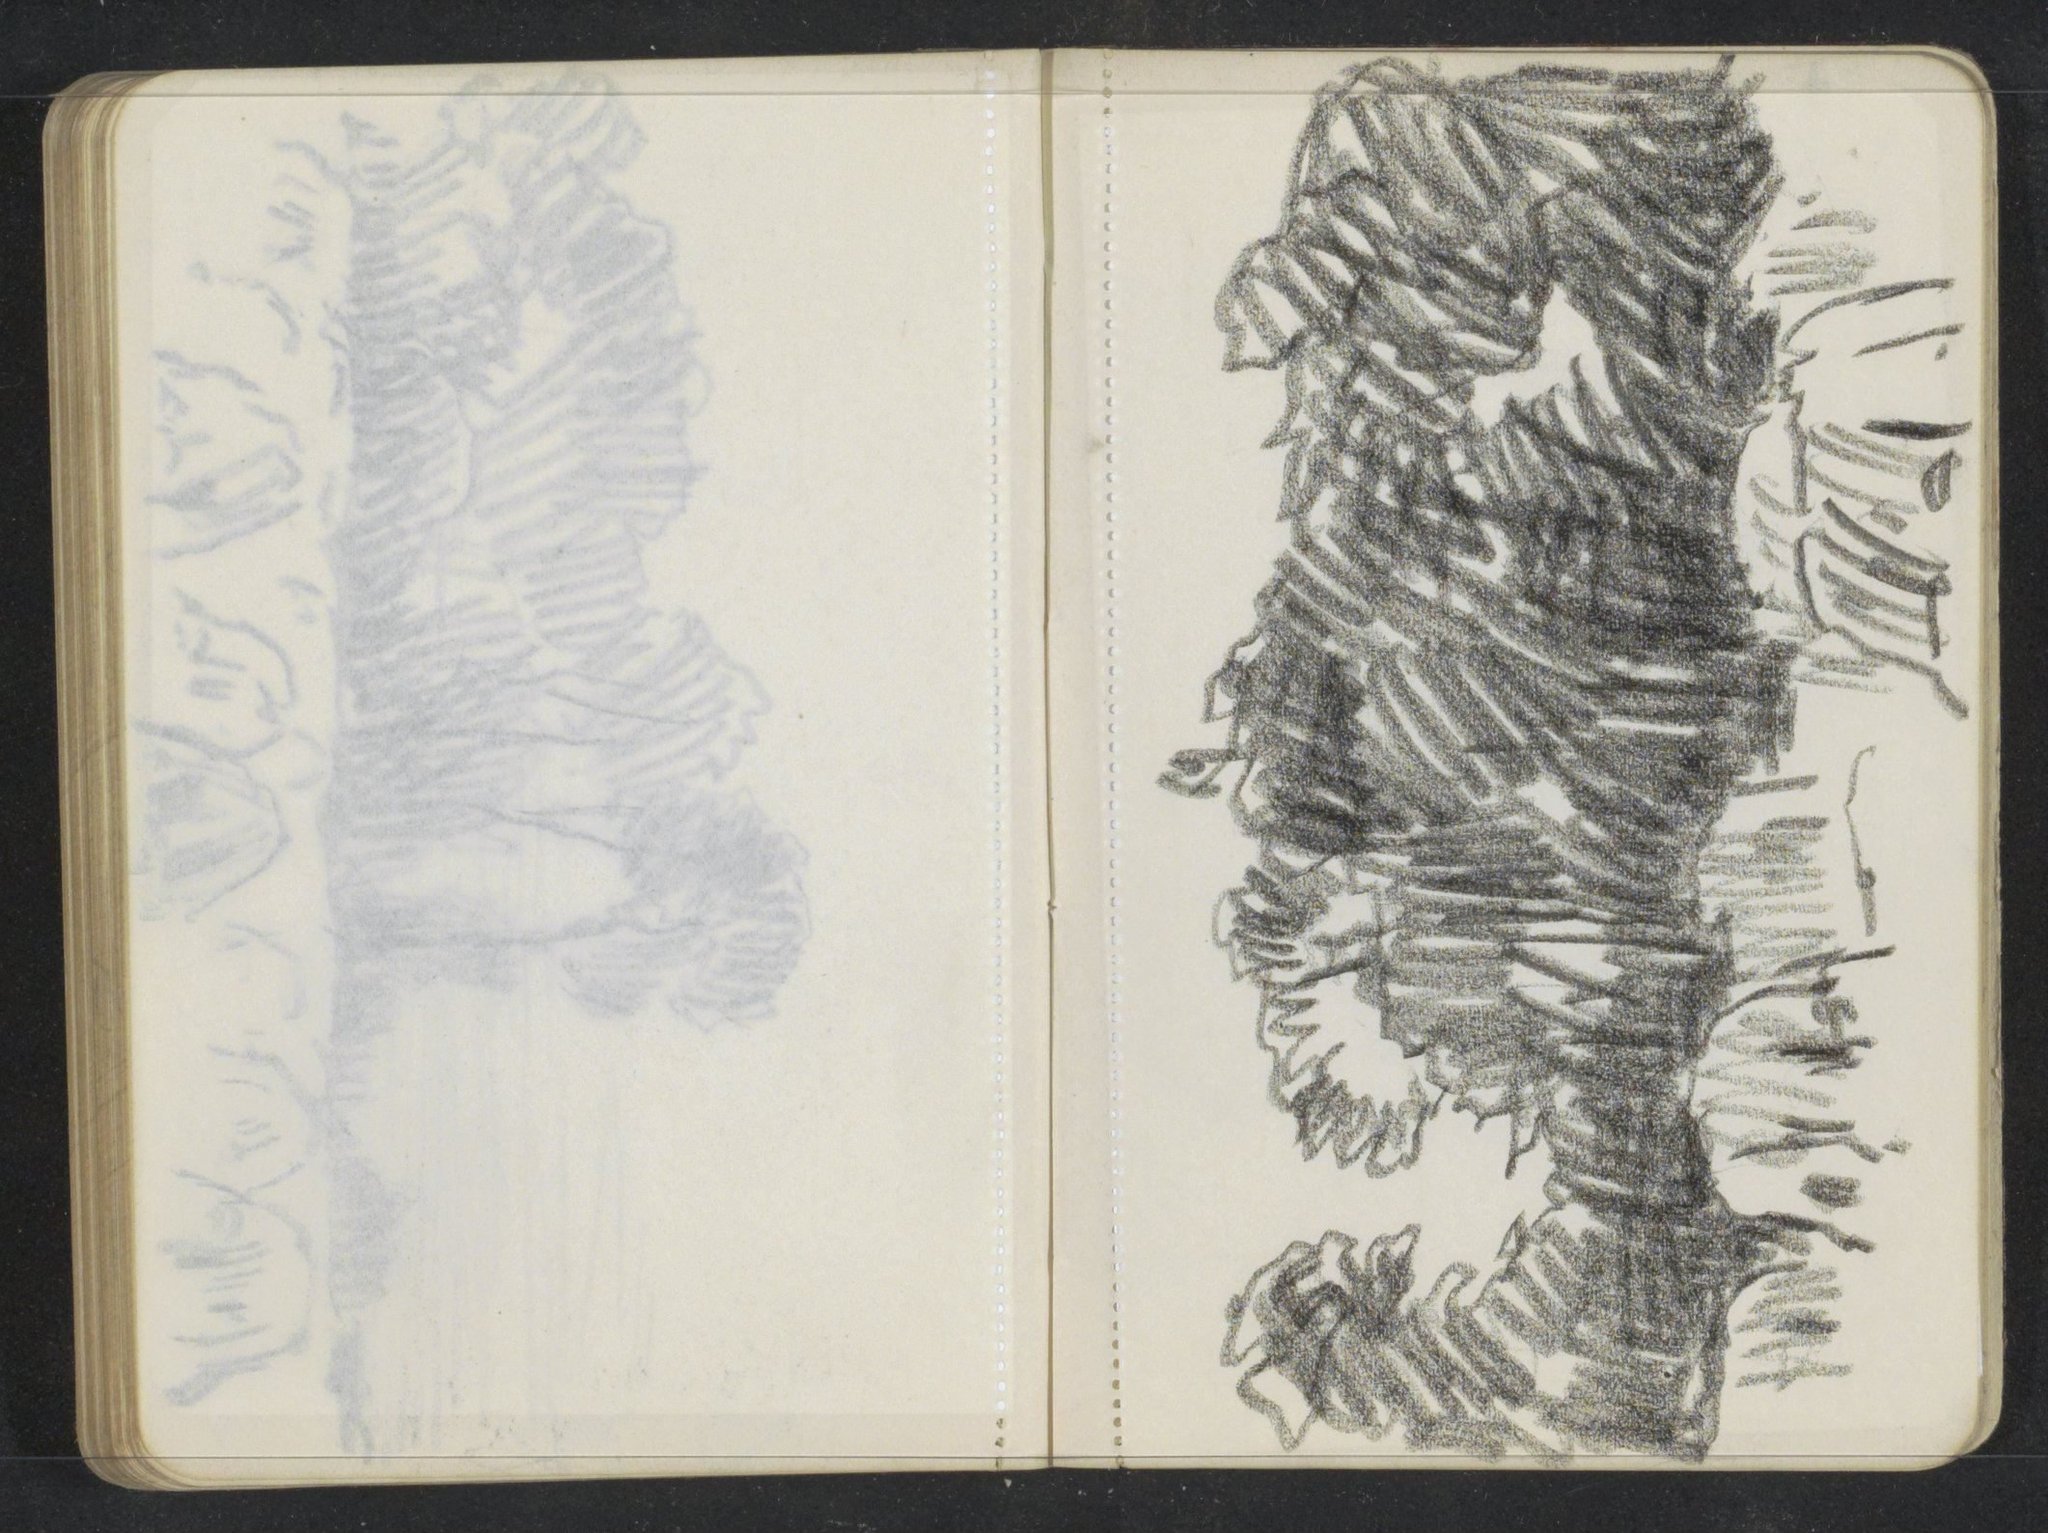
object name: sketchbook leaf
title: Hooioppers en bomen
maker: alexander shilling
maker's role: draughtsman, print maker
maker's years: 1859-1937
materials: chalk, paper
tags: trees, hay-cock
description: Blad 80 recto uit een schetsboek met 91 bladen.